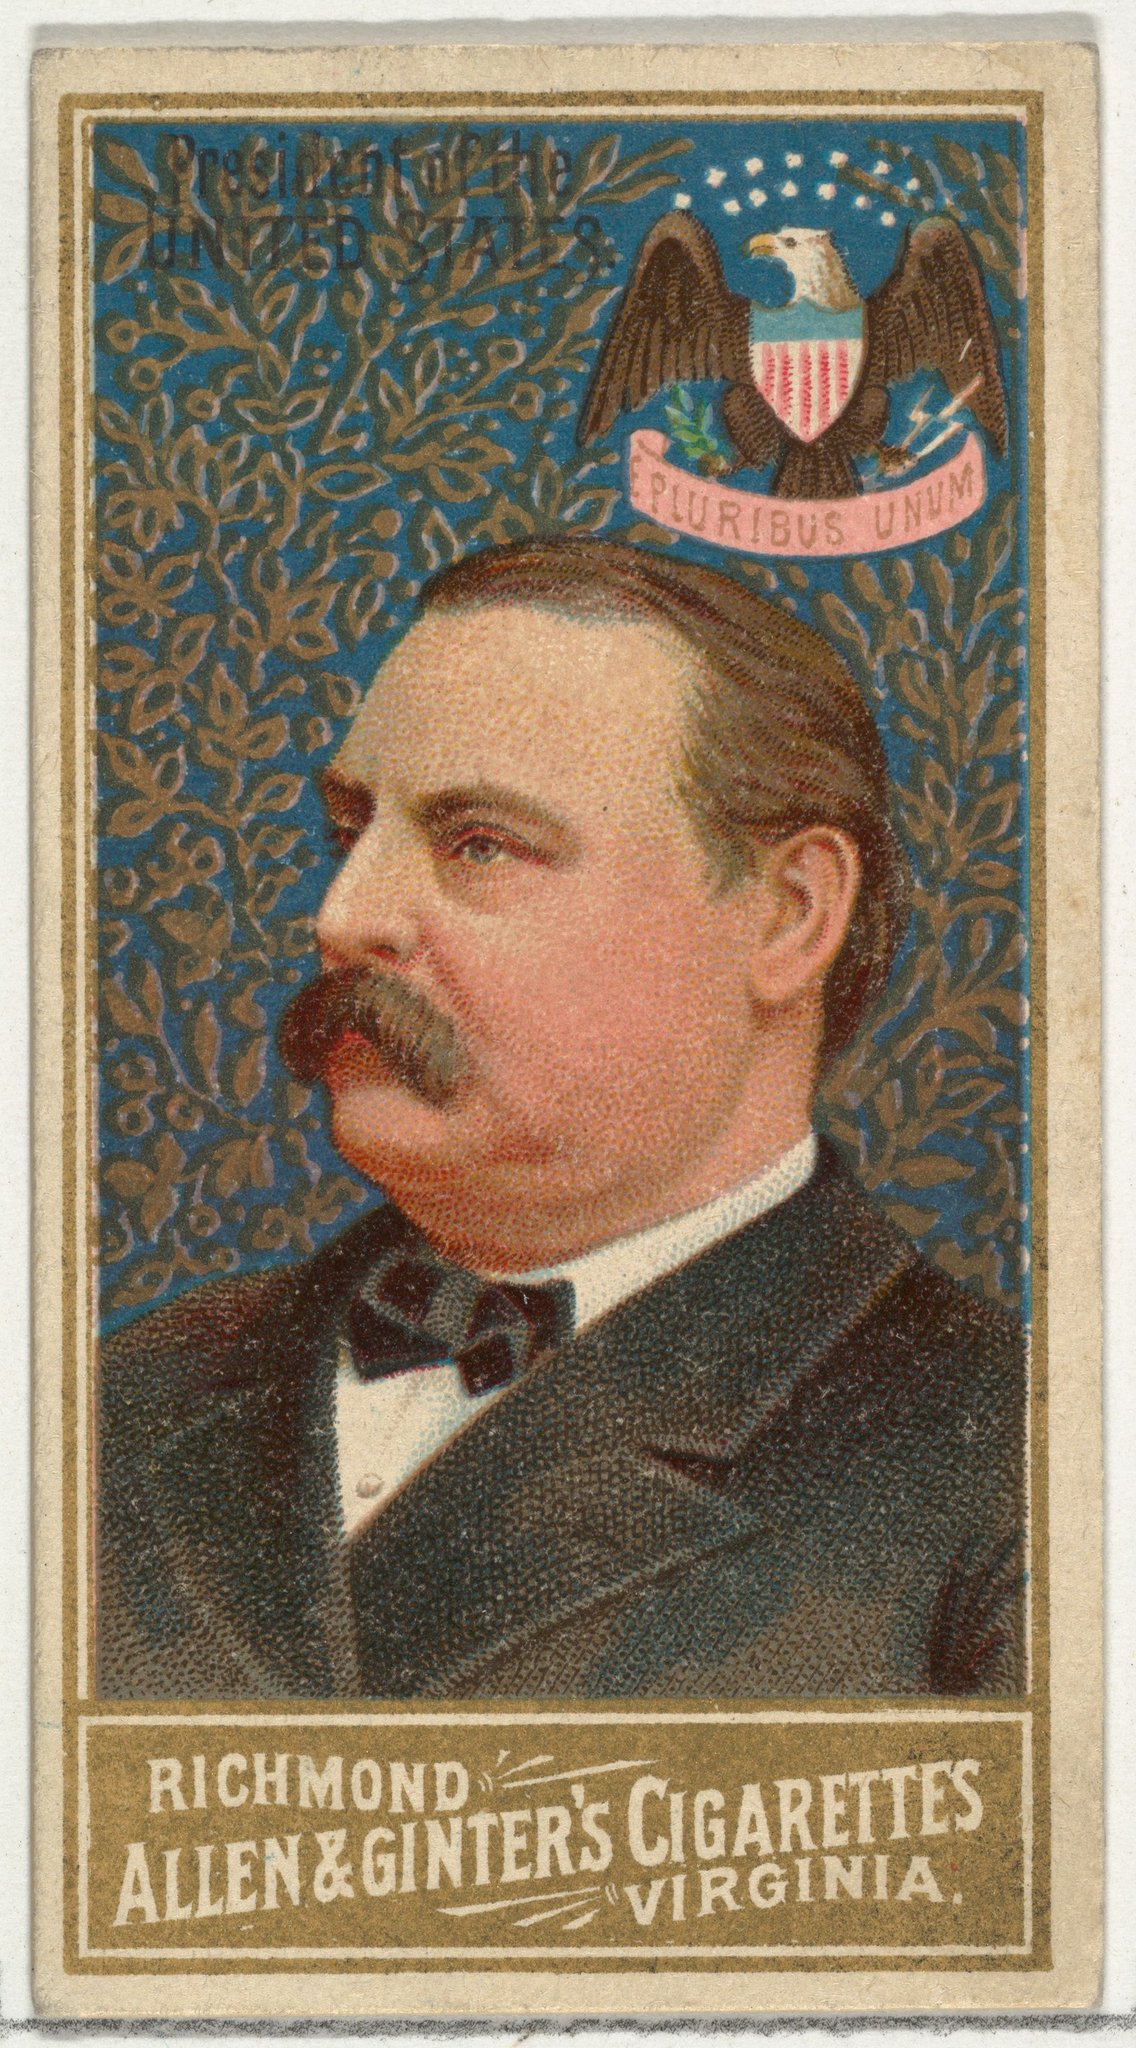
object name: print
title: President of the United States, from World's Sovereigns series (N34) for Allen & Ginter Cigarettes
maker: allen & ginter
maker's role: publisher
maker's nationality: american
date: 1889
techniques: color lithograph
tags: men,portraits,coat of arms